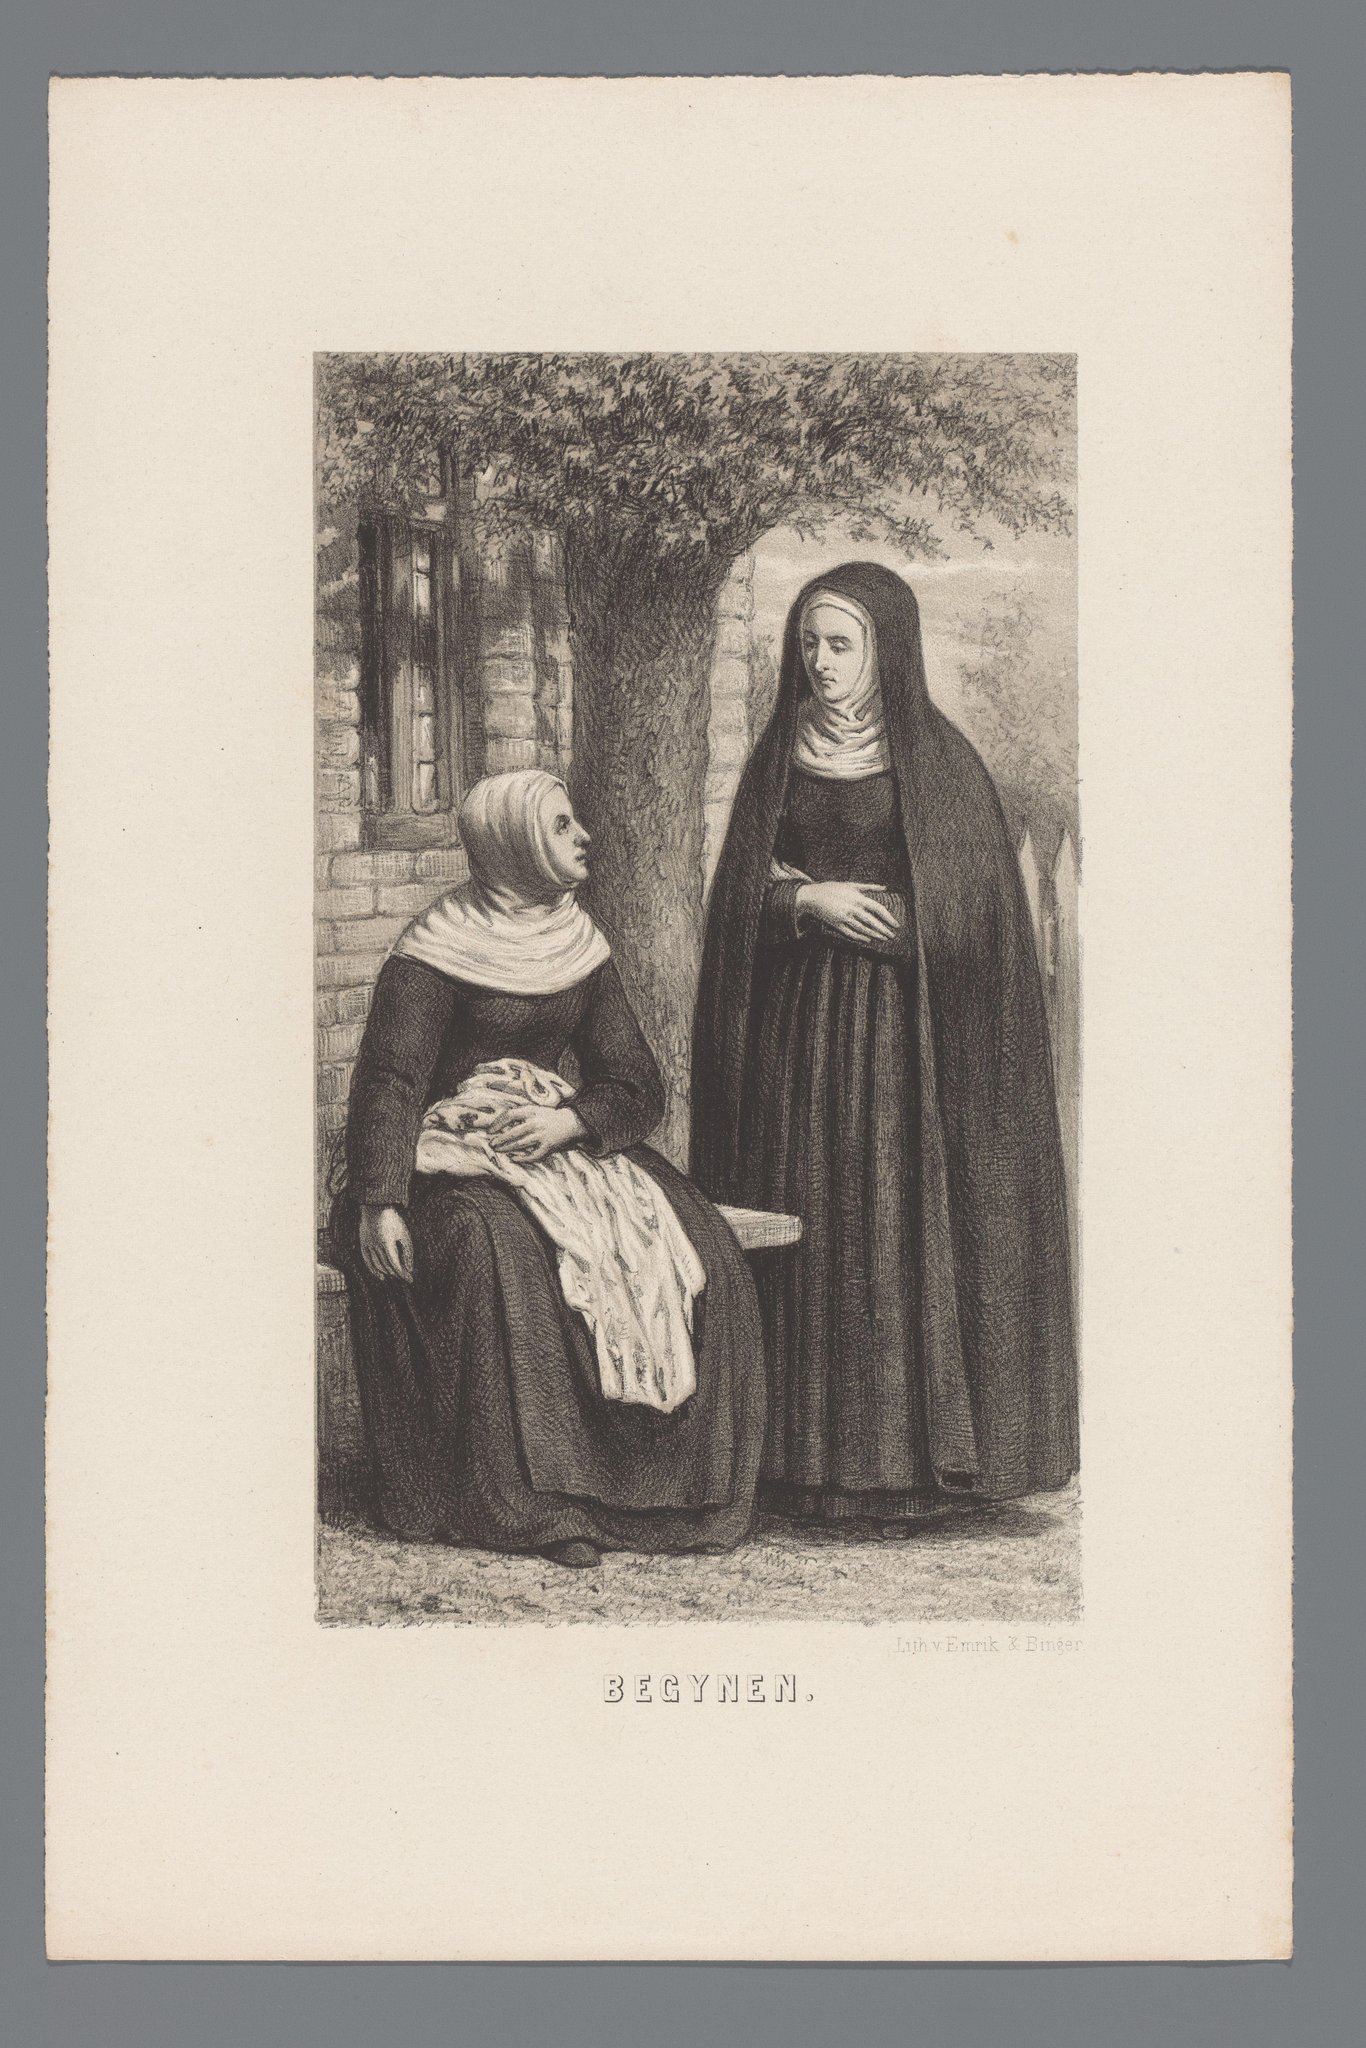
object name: print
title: Begynen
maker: david van der kellen (1827-1895)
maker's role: draughtsman, print maker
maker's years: 1827-1895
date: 1865-1874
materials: paper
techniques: tone lithography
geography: the hague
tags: trees, nun(s)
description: Prent waarschijnlijk uit: Hofdijk, W.J. De klooster-orden in Nederland. Haarlem: A.C. Kruseman, 1865. Of uit de editie van 1874.